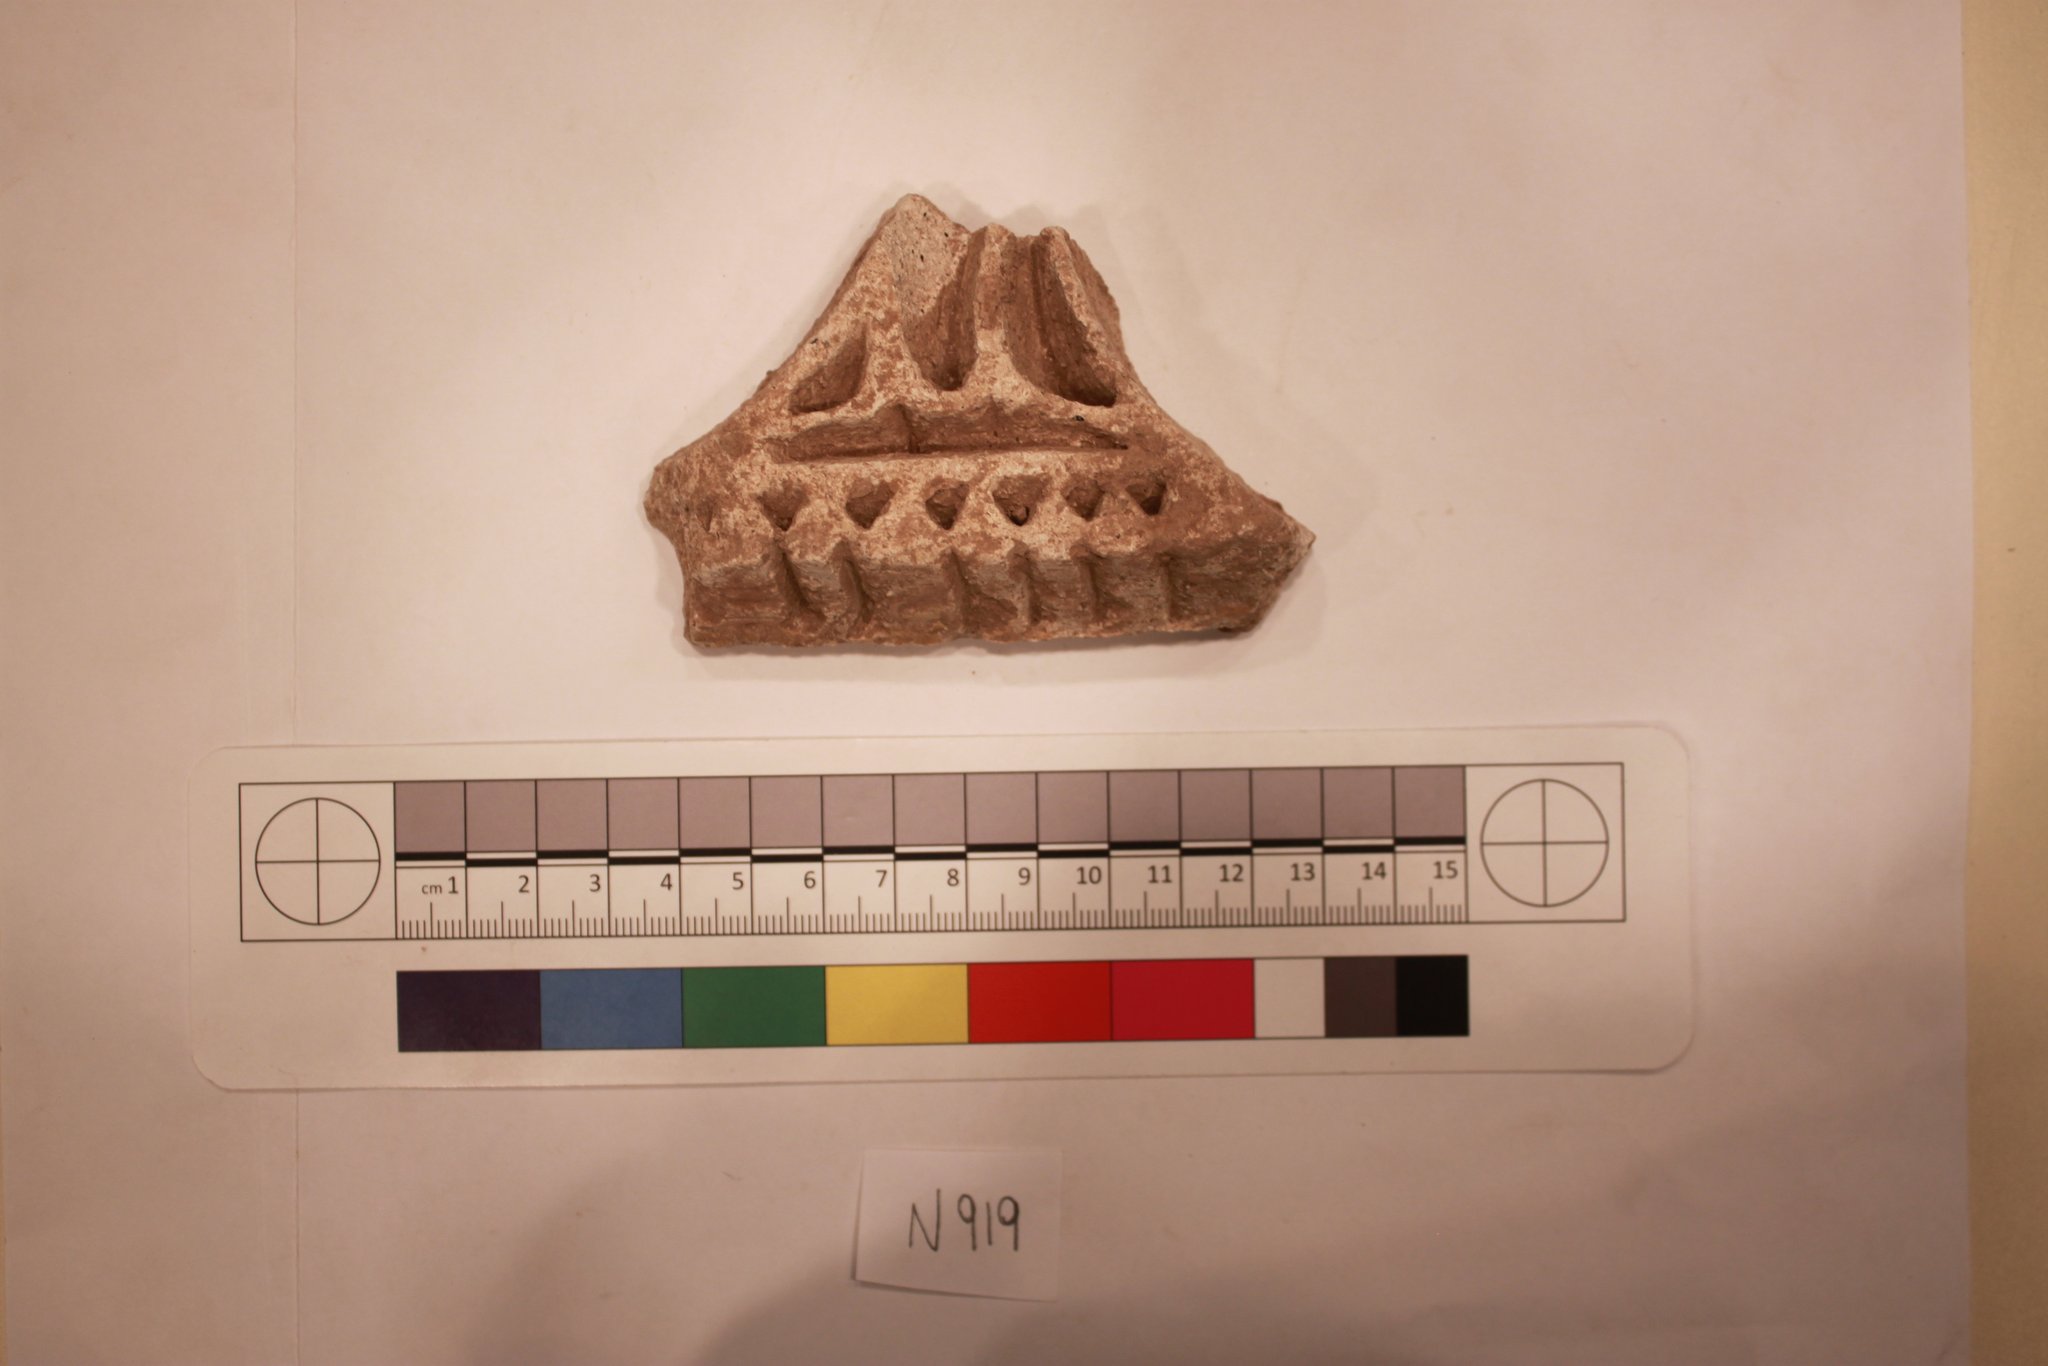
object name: fragment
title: Stucco Fragment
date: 701-1200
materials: plaster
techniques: carving, painting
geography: iran